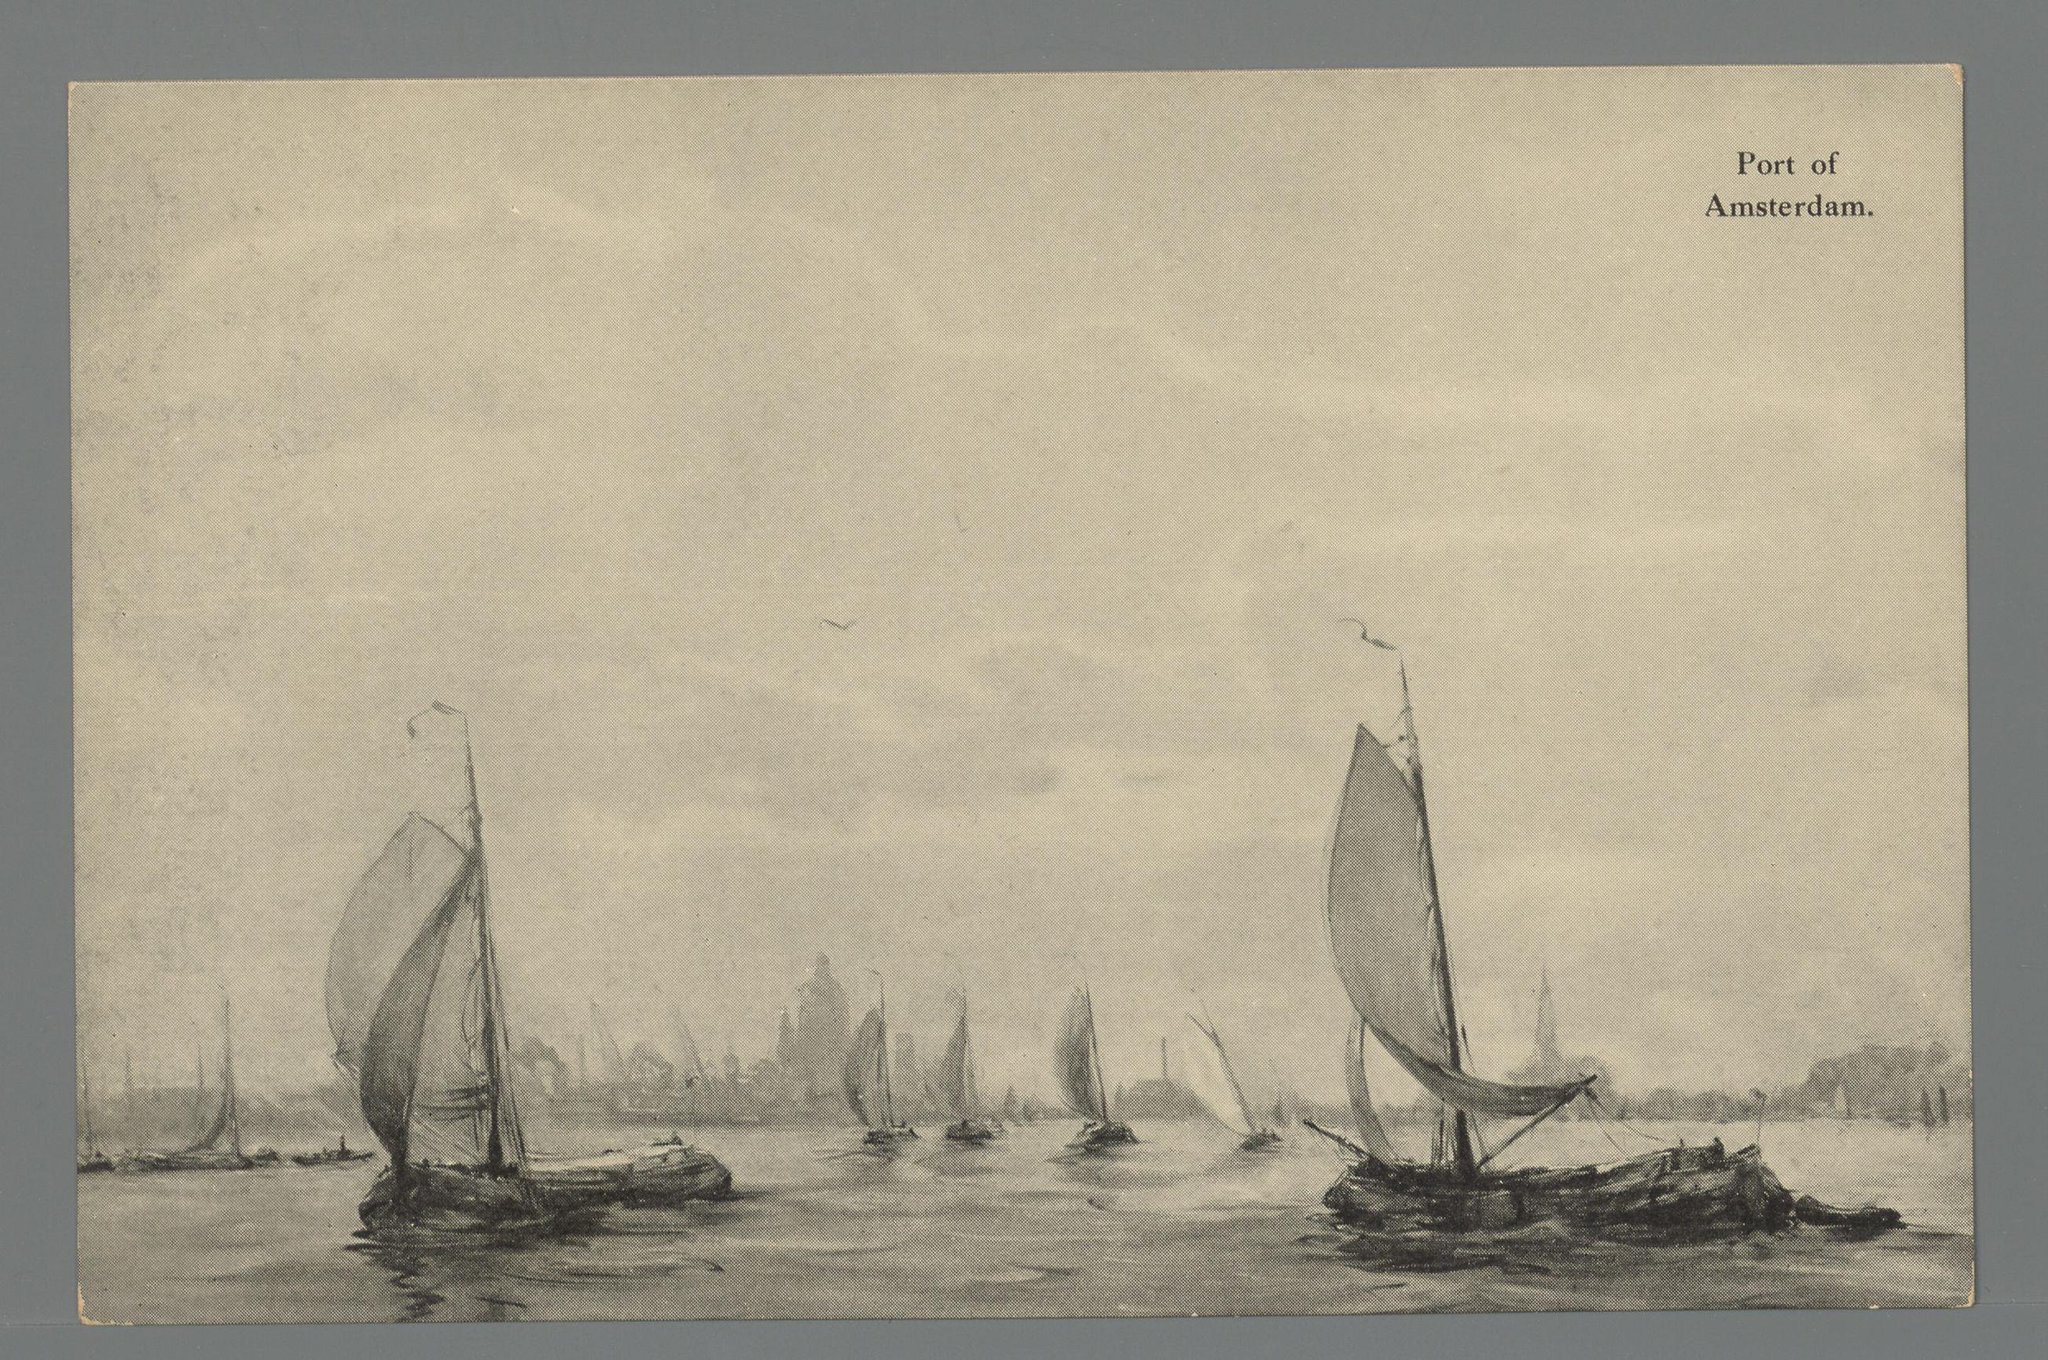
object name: reproduction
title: Reproductie van: Port of Amsterdam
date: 1912-1930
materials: cardboard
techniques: autotype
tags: harbour, sailing-ship, sailing-boat, port of amsterdam